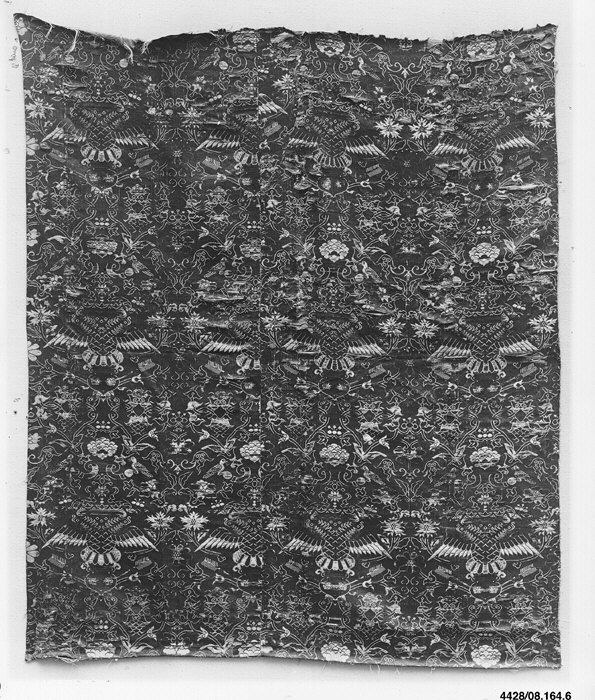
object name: piece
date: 1551-1600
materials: silk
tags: birds,flowers